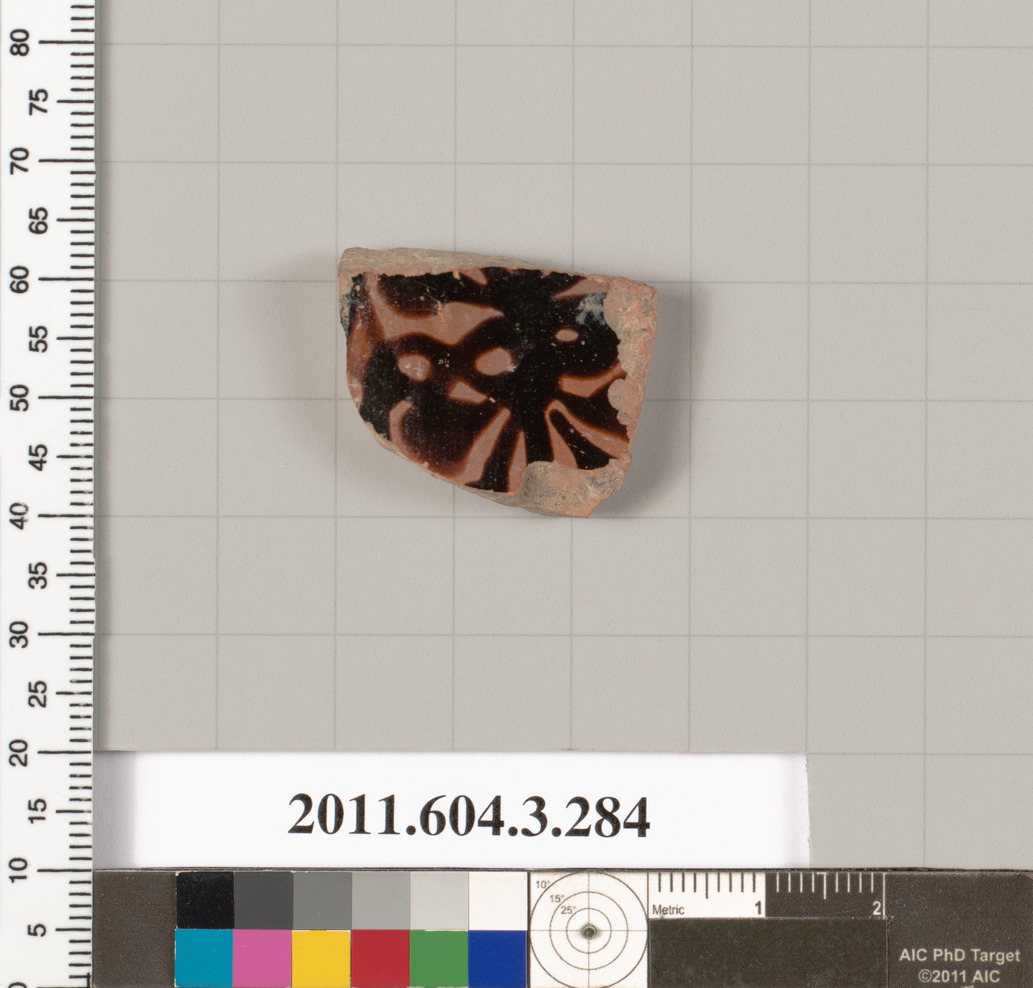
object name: neck amphora fragment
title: Terracotta fragment of a neck-amphora (jar)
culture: greek, attic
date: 520-510 BCE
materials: terracotta